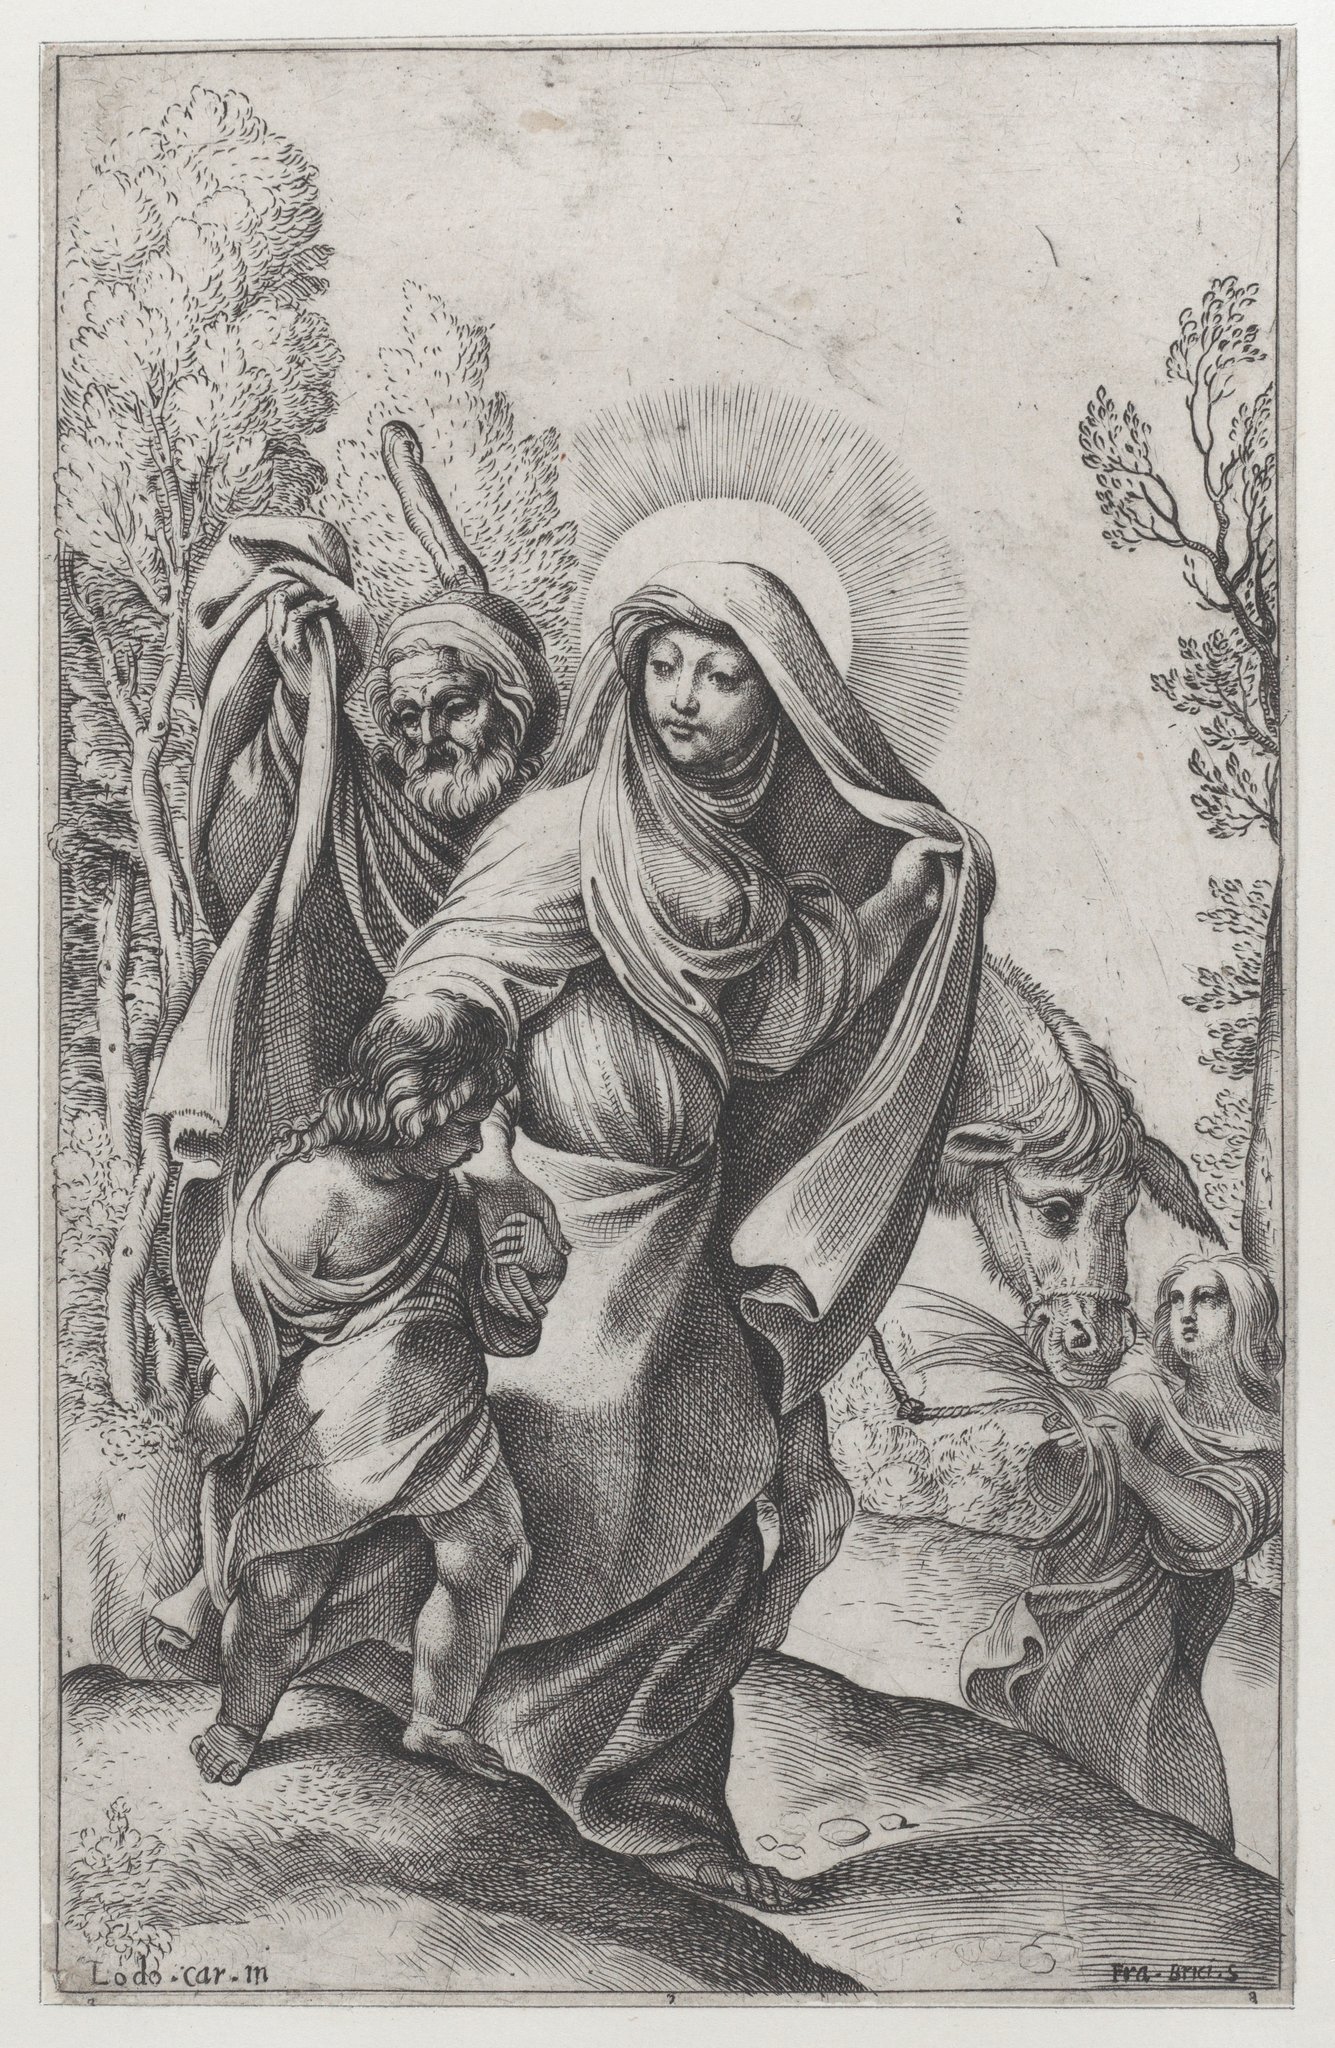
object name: print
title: The Return from Egypt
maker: francesco brizio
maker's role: artist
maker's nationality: italian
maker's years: 1569-1623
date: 1595-1623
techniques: engraving